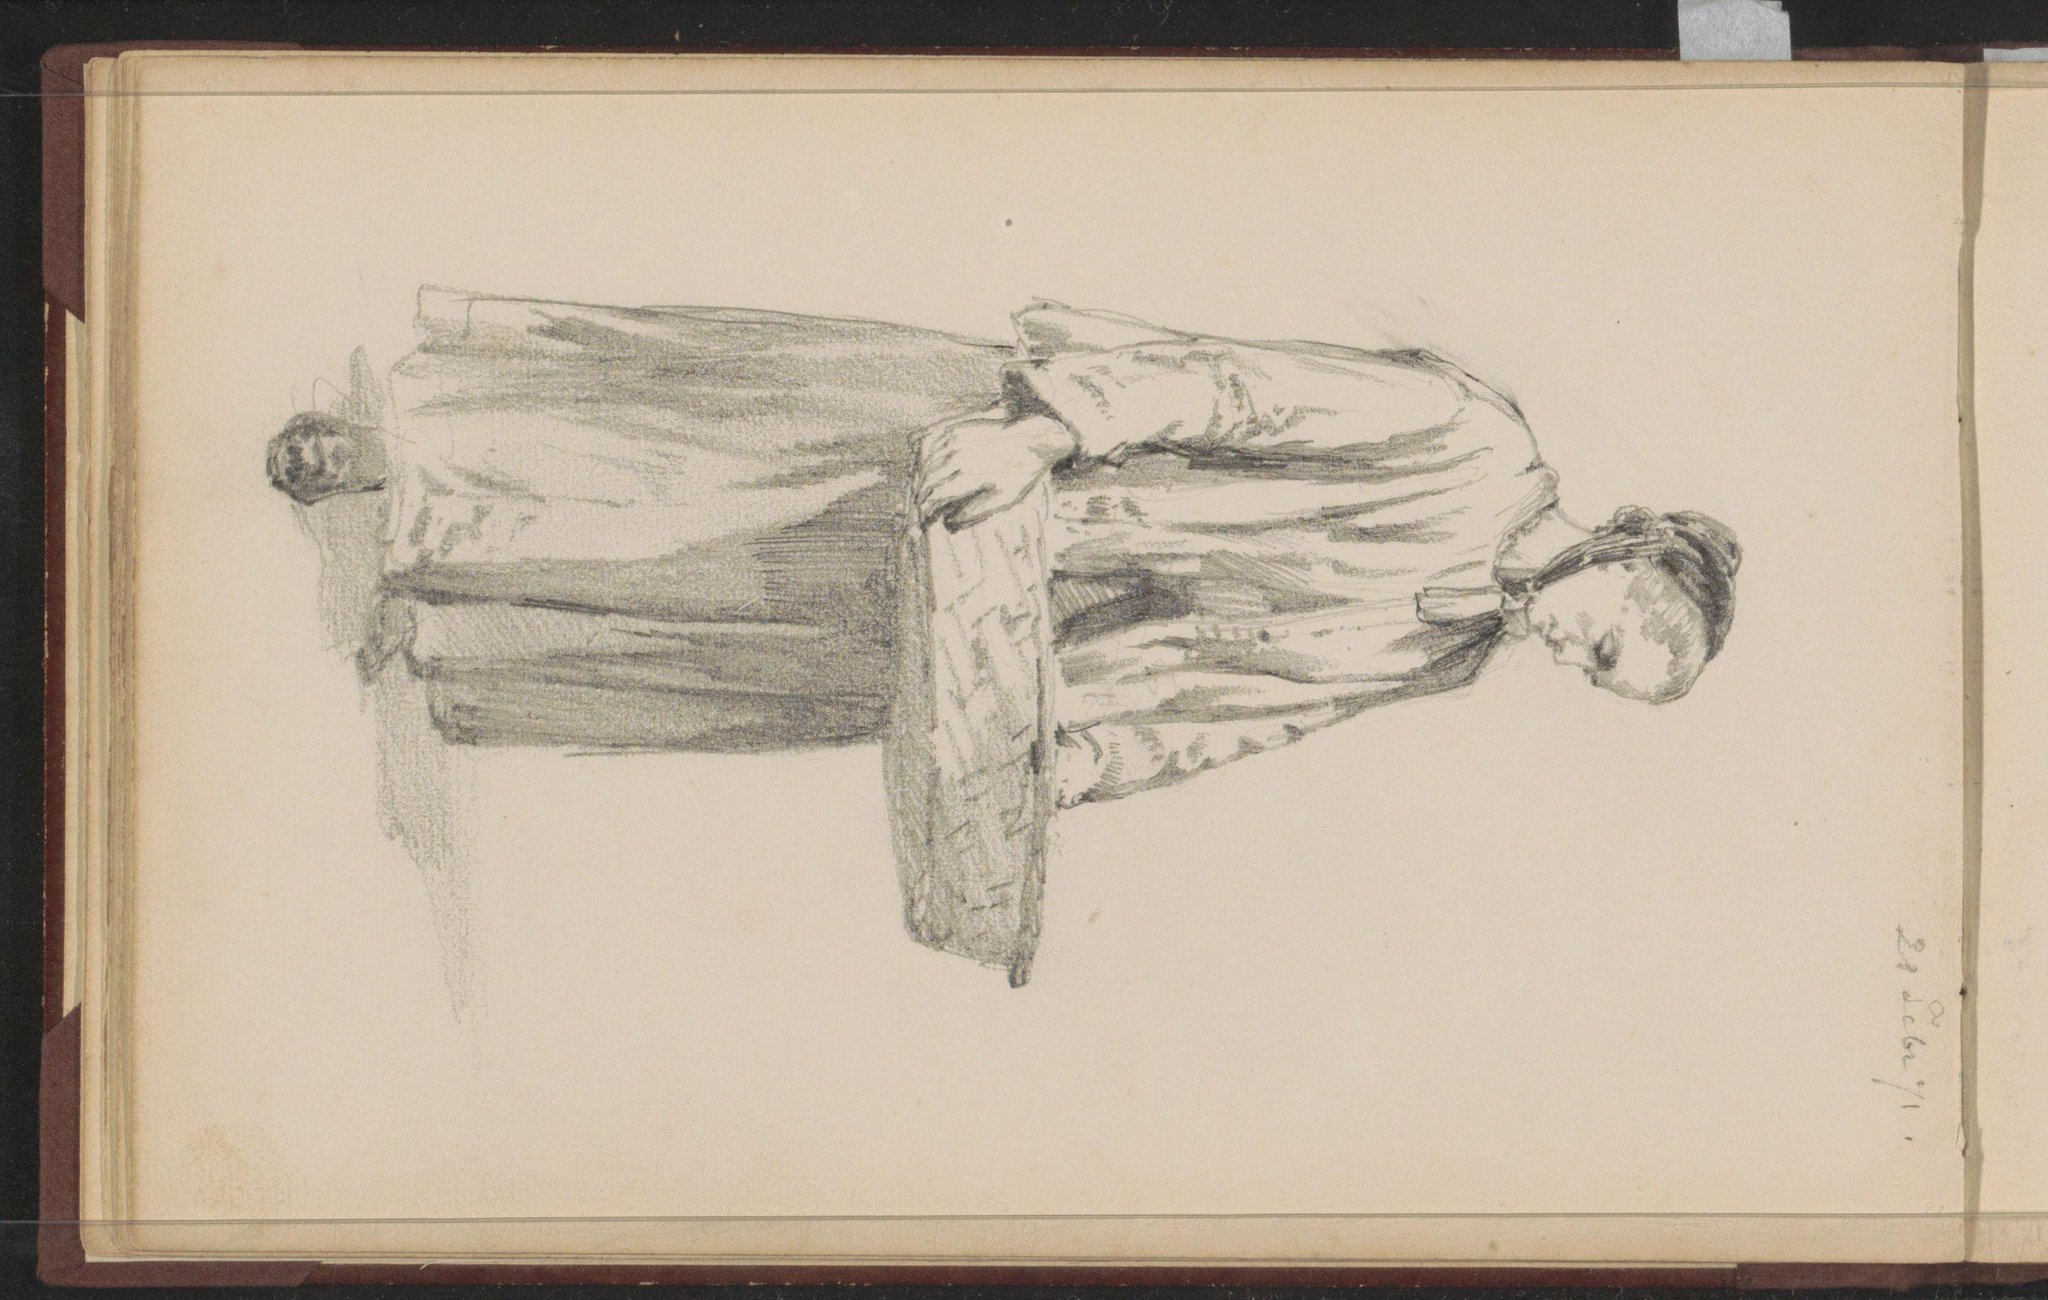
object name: sketchbook leaf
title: Vrouw met een mand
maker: cornelis springer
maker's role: draughtsman, painter, print maker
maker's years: 1817-1891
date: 1871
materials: paper, pencil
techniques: stumping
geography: netherlands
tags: container made of plant material other than wood: basket, standing figure - aa - female human figure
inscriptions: date: ‘21 Febr 71’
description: Staande vrouw met een mand. Blad 9 verso uit een schetsboek met 39 bladen, deels vervaardigd te Ulm en Leiden.